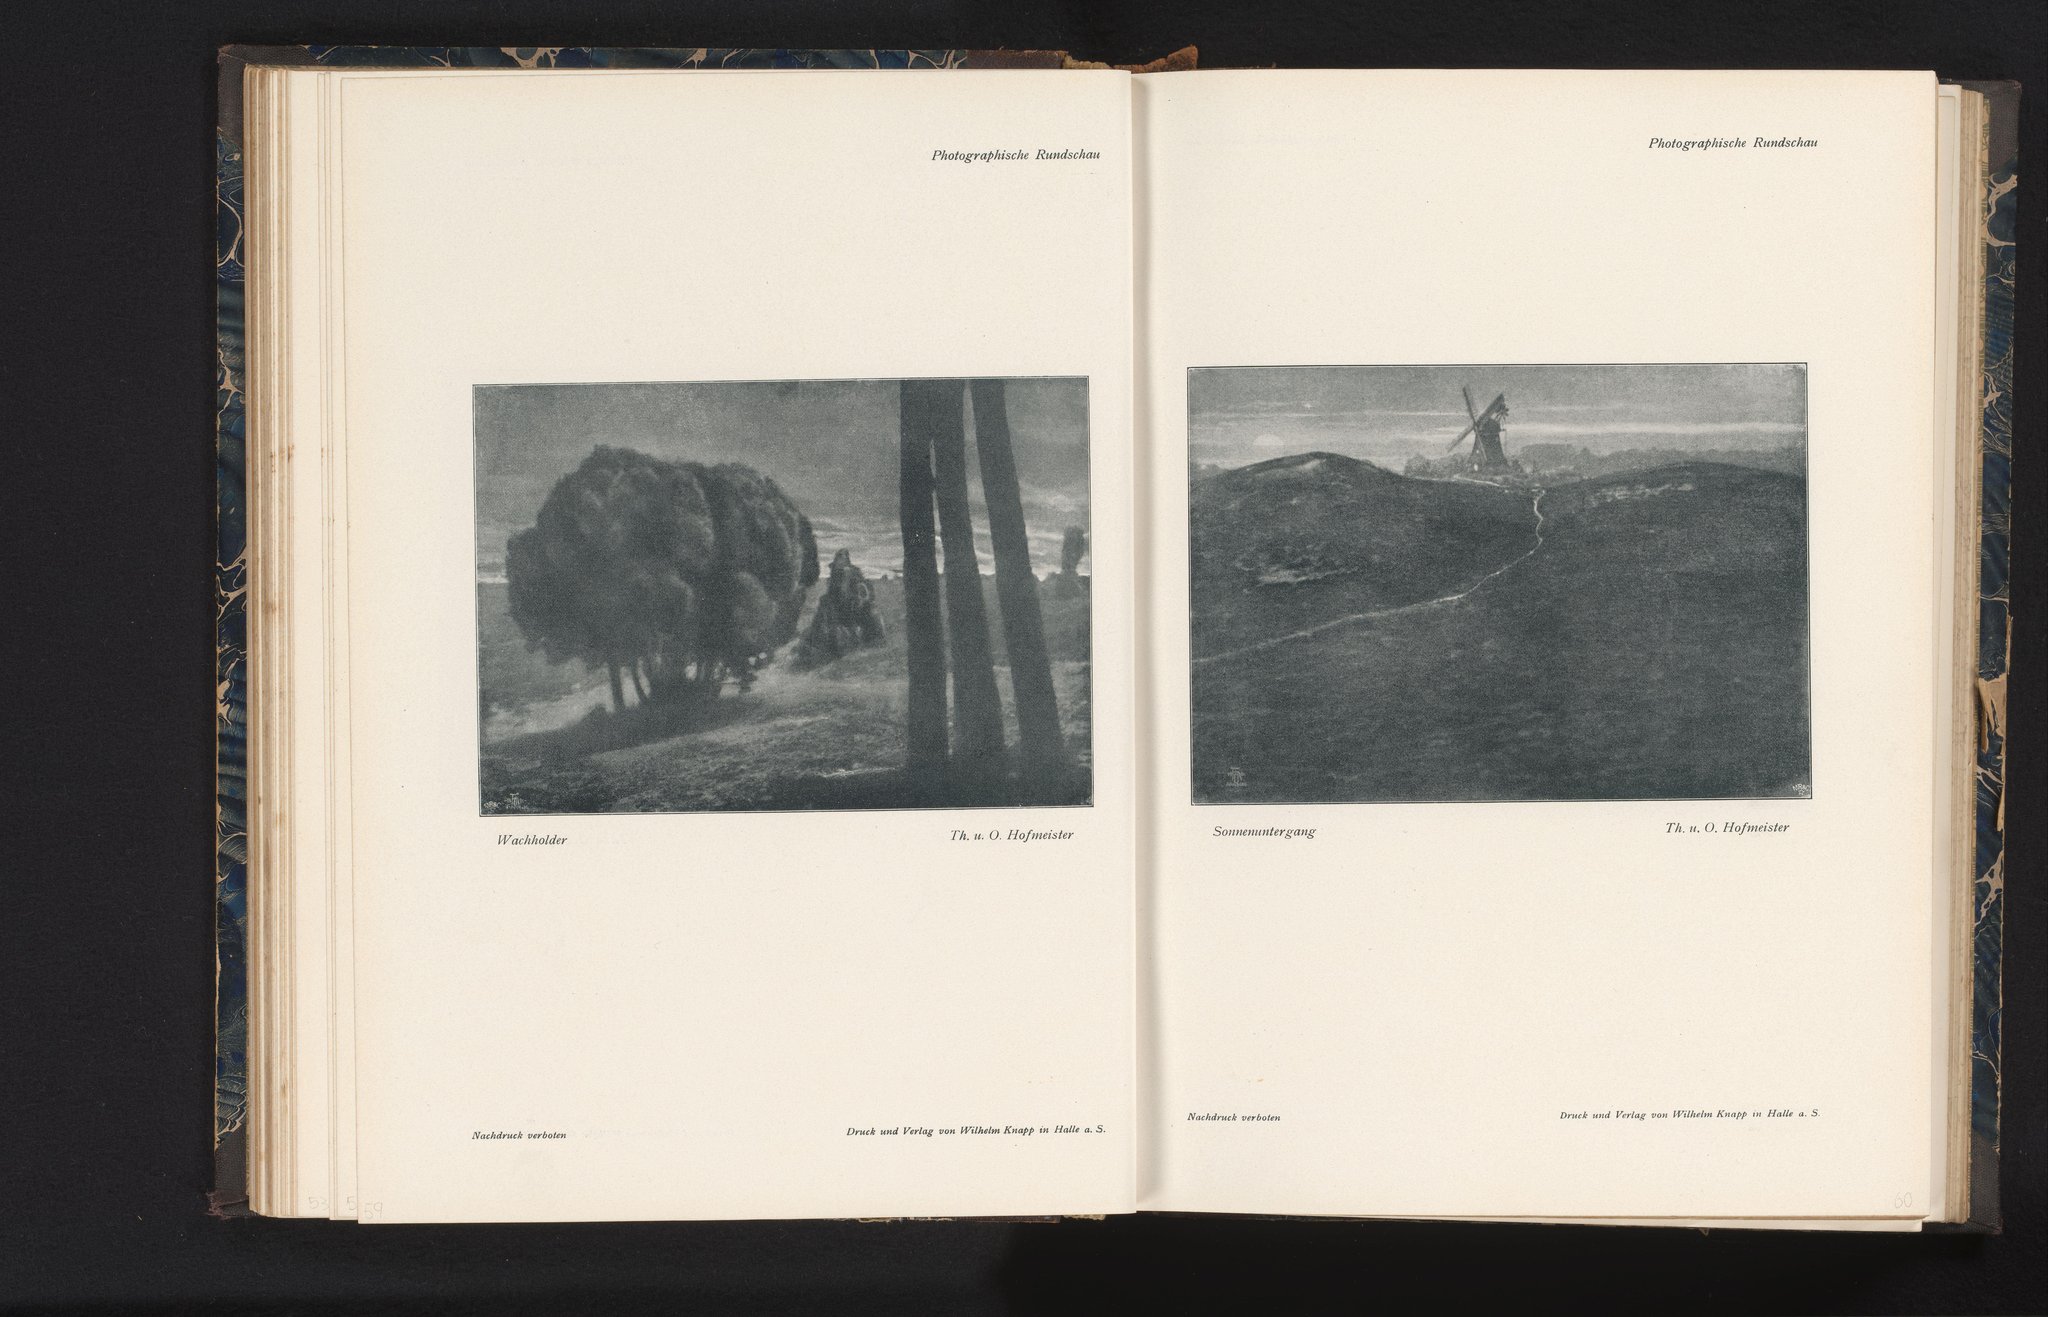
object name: photomechanical print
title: Gezicht op een molen in een landschap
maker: th. u. o. hofmeister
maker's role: fotograaf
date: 1897-1902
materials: paper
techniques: autotype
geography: halle an der saale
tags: windmill in landscape